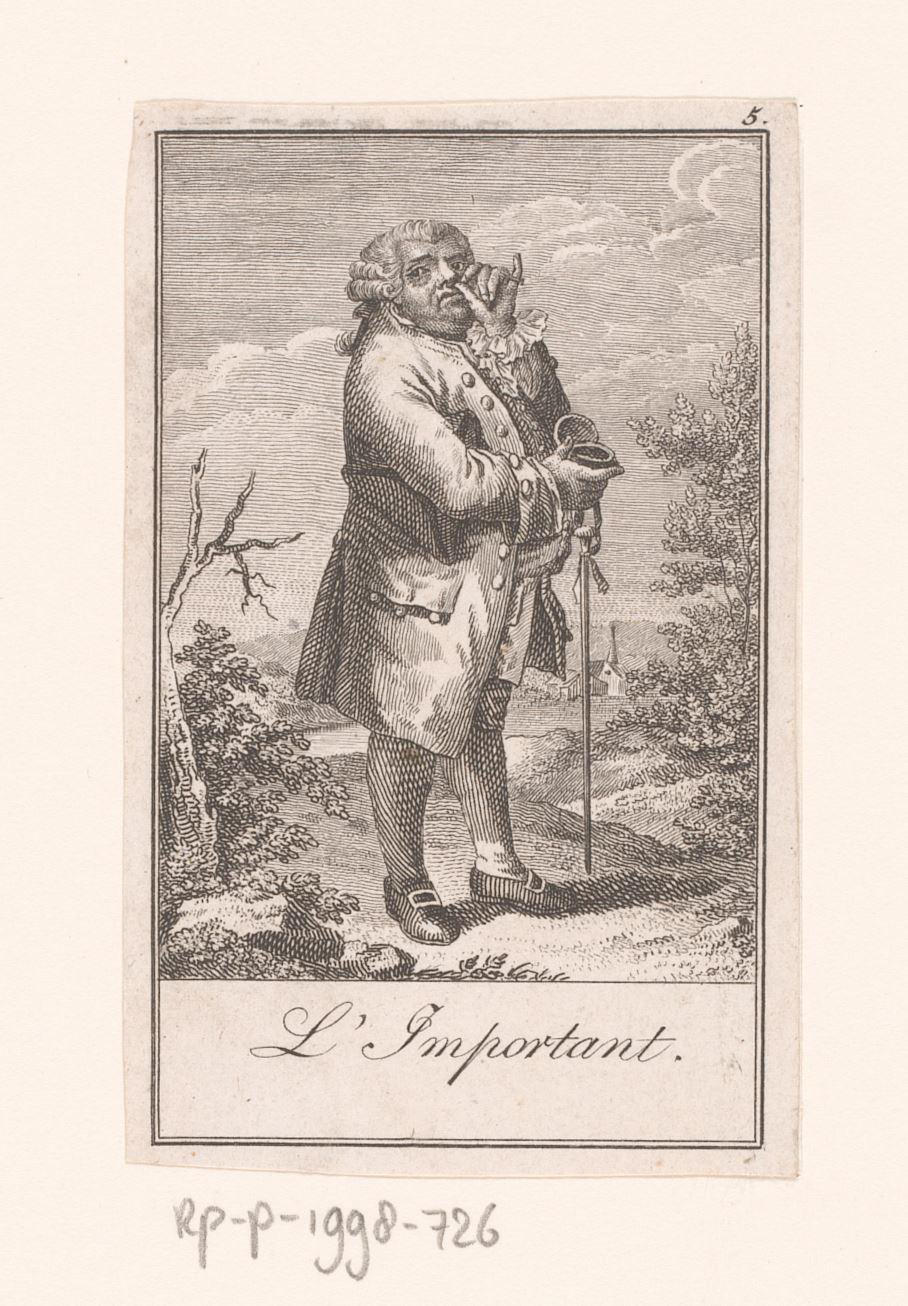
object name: print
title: L'Important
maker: karl heinrich grünler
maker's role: print maker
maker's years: 1761-1823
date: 1771-1823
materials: paper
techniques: etching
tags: importance, preponderance, adult man, snuff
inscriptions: collector's mark: Lugt 2228